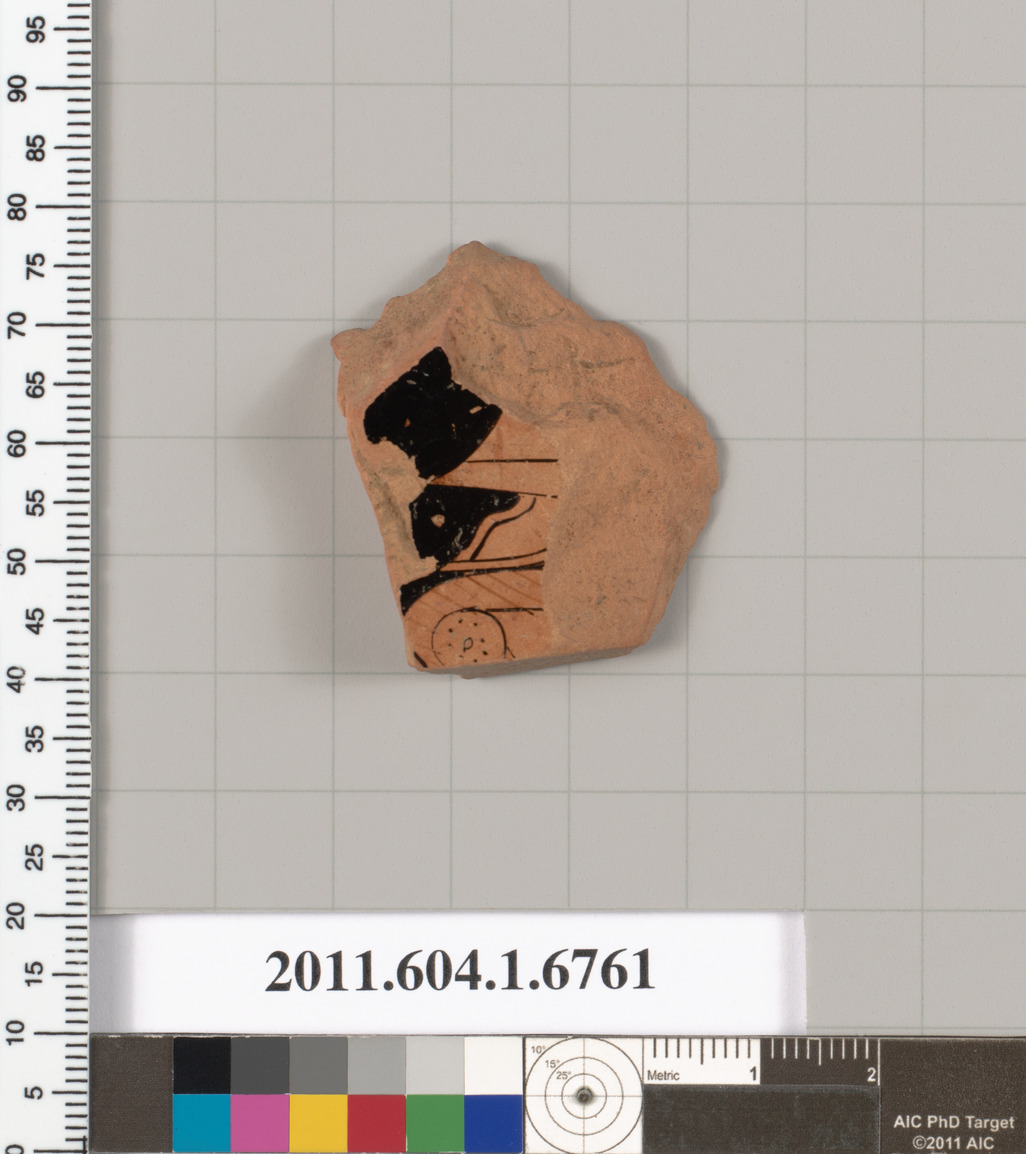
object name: kylix fragment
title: Terracotta fragment of a kylix (drinking cup)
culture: greek, attic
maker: onesimos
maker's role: artist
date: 490-470 BCE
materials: terracotta